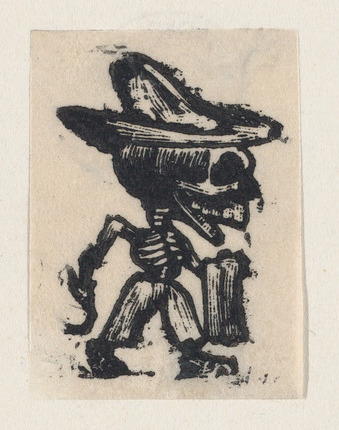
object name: print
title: Skeleton wearing a hat and carrying a towel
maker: josé guadalupe posada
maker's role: artist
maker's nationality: mexican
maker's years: 1852-1913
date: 1880-1910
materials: zinc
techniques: etching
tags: skeletons